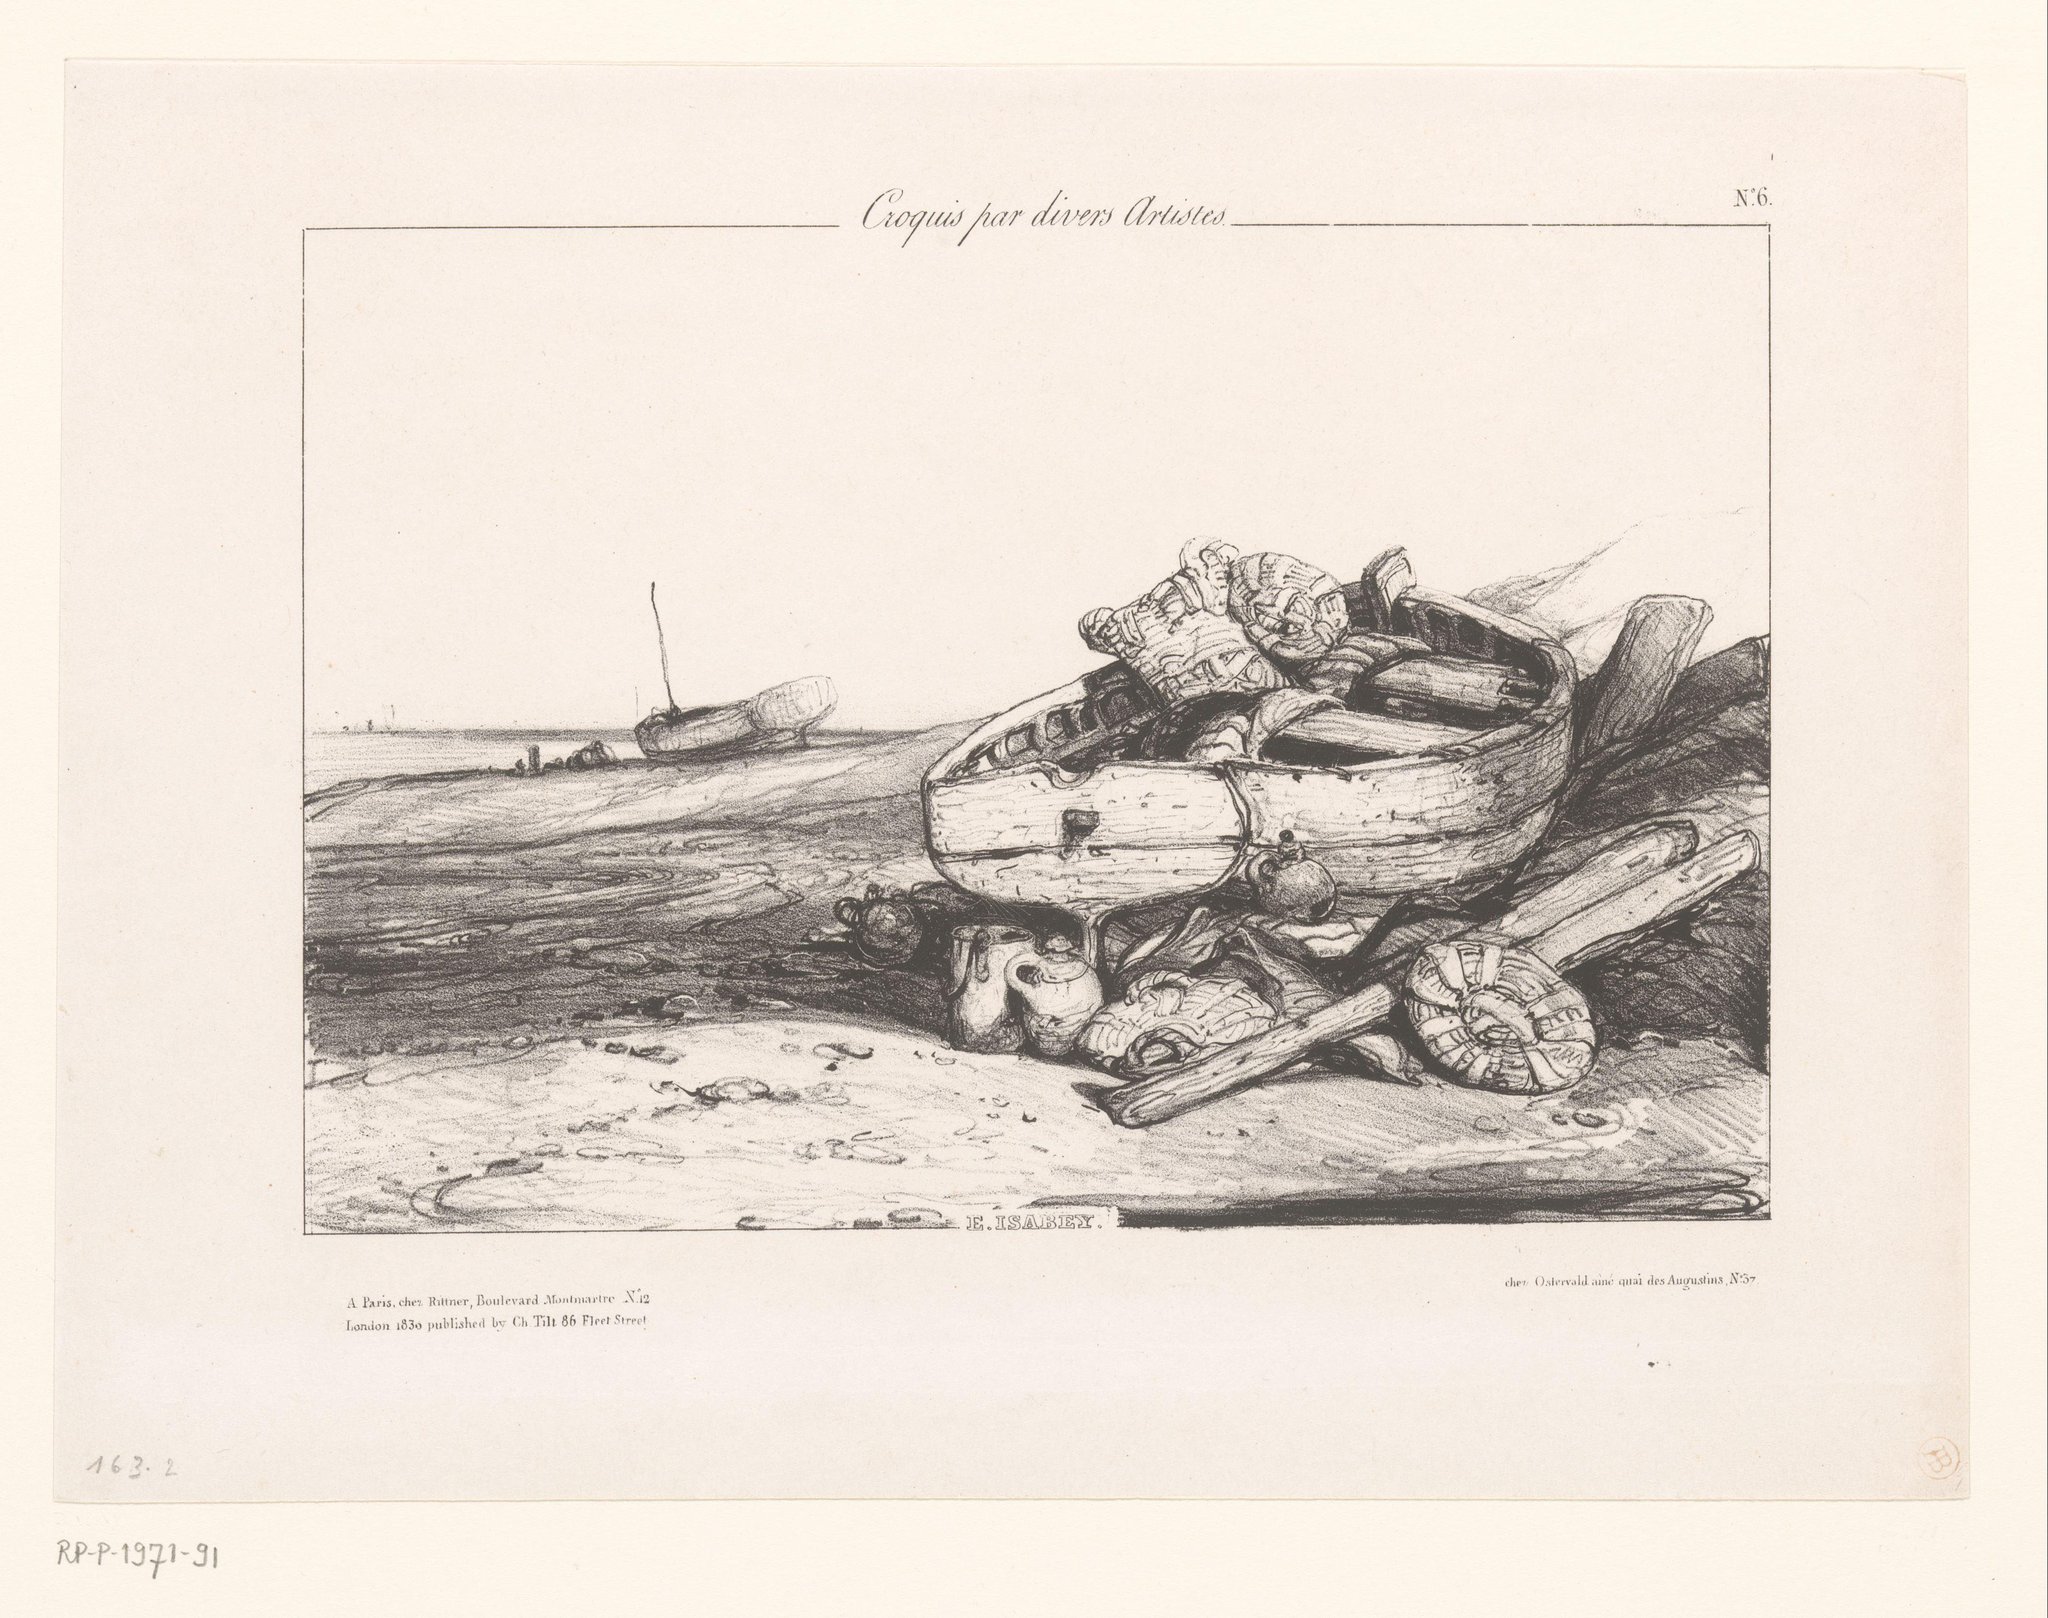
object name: print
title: Croquis par divers Artistes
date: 1830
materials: paper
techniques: lithograph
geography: london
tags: rowing-boat, canoe, etc., beach, sea and coastal fishery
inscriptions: collector's mark: Lugt 2228a, collector's mark: Lugt 2760, stamp: Lugt 76